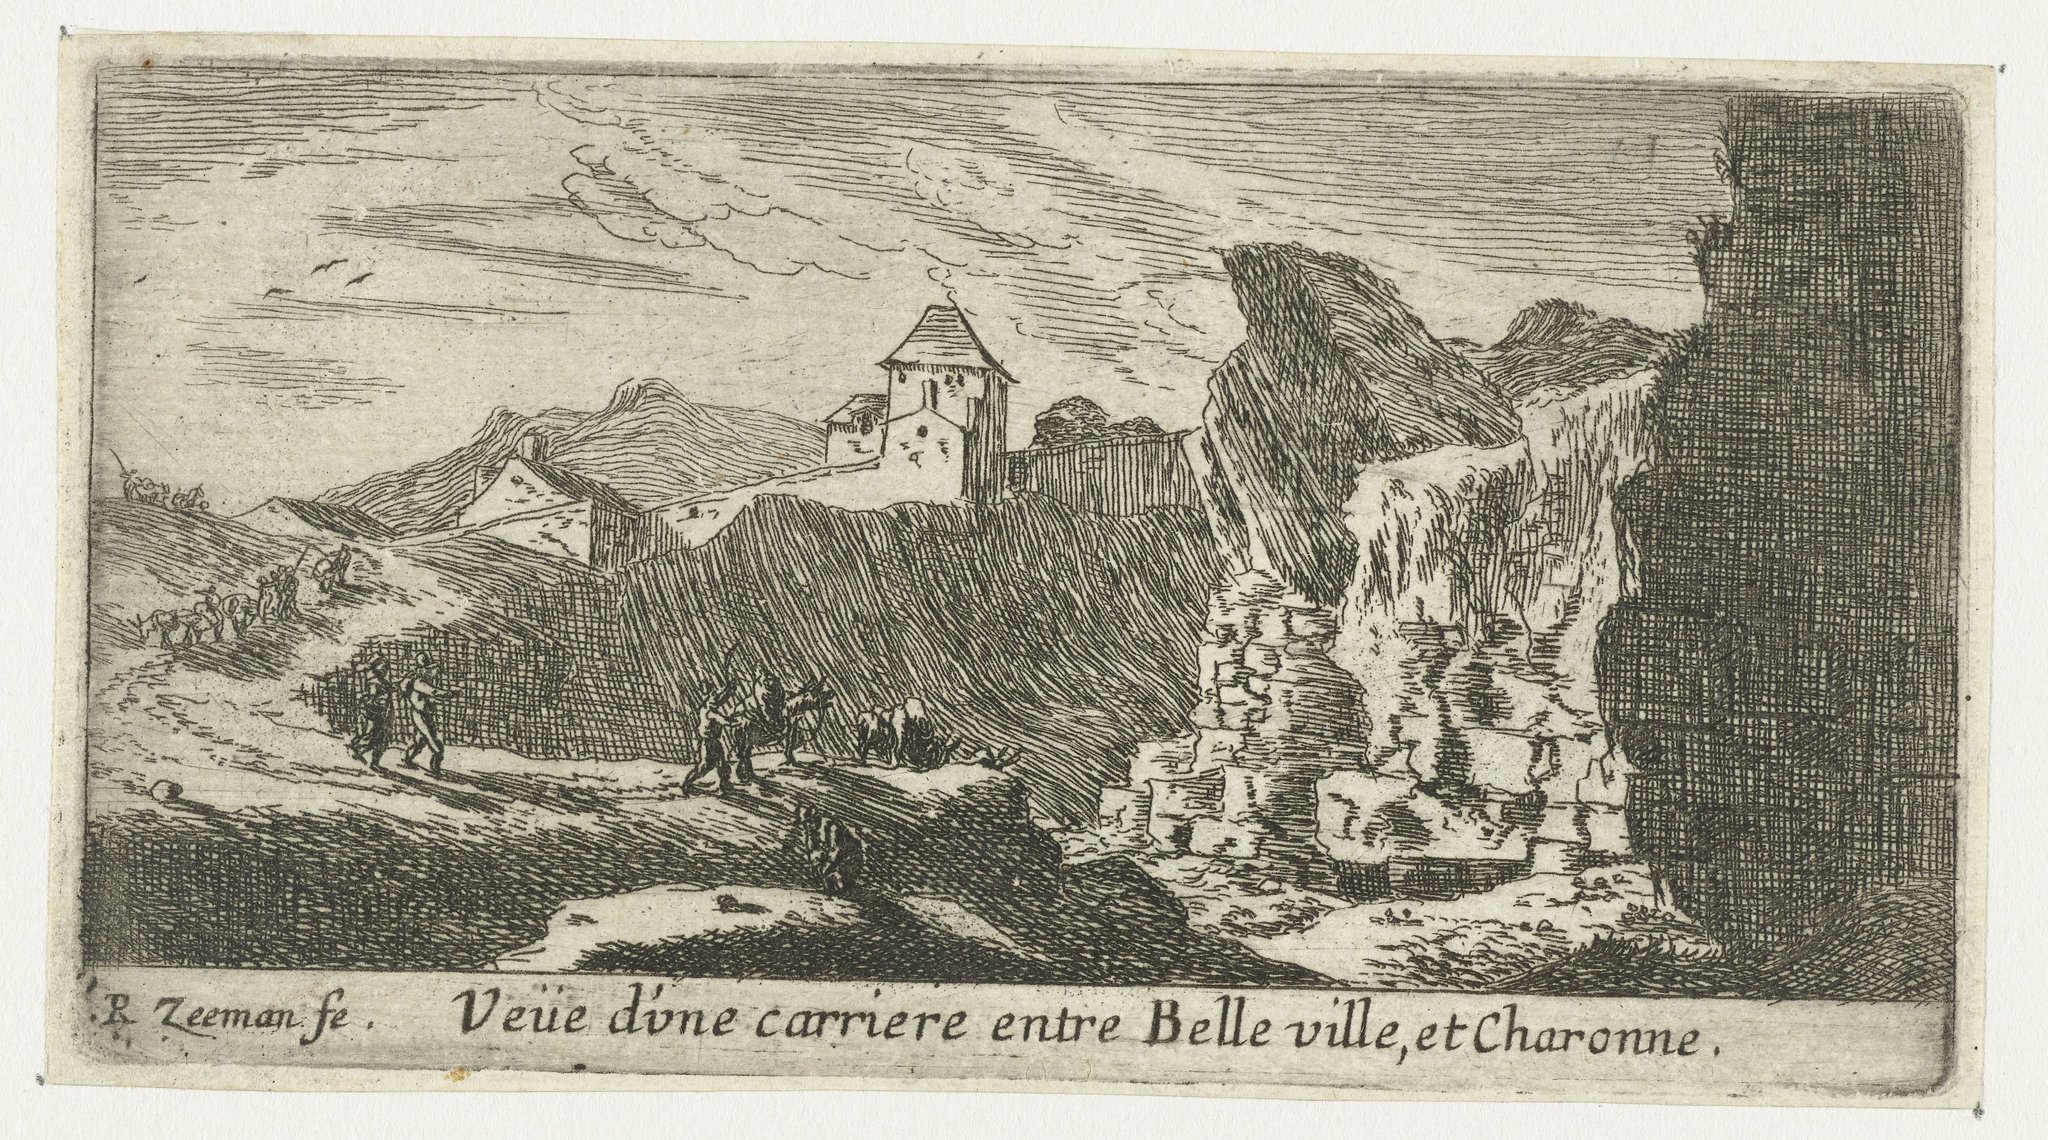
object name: print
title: Veüe d'une carriere entre Belle ville, et Charonne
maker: reinier nooms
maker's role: draughtsman, painter, print maker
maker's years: 1623-1664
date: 1650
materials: paper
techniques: etching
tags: quarry, paris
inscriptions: collector's mark: Lugt 2228, stamp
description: Gezicht op een steengroeve tussen Belleville en Charonne, tegenwoordig Parijs. Naast de groeve een gebouw en een weg met daarop mensen en hun ezels.